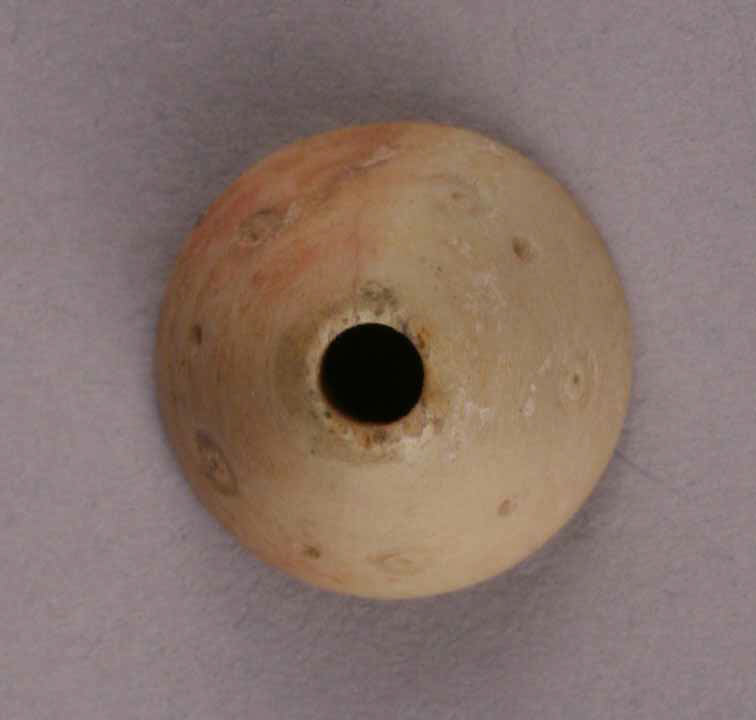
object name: button or bead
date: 801-1000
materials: bone, paint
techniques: incising, inlay, tinting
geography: iran